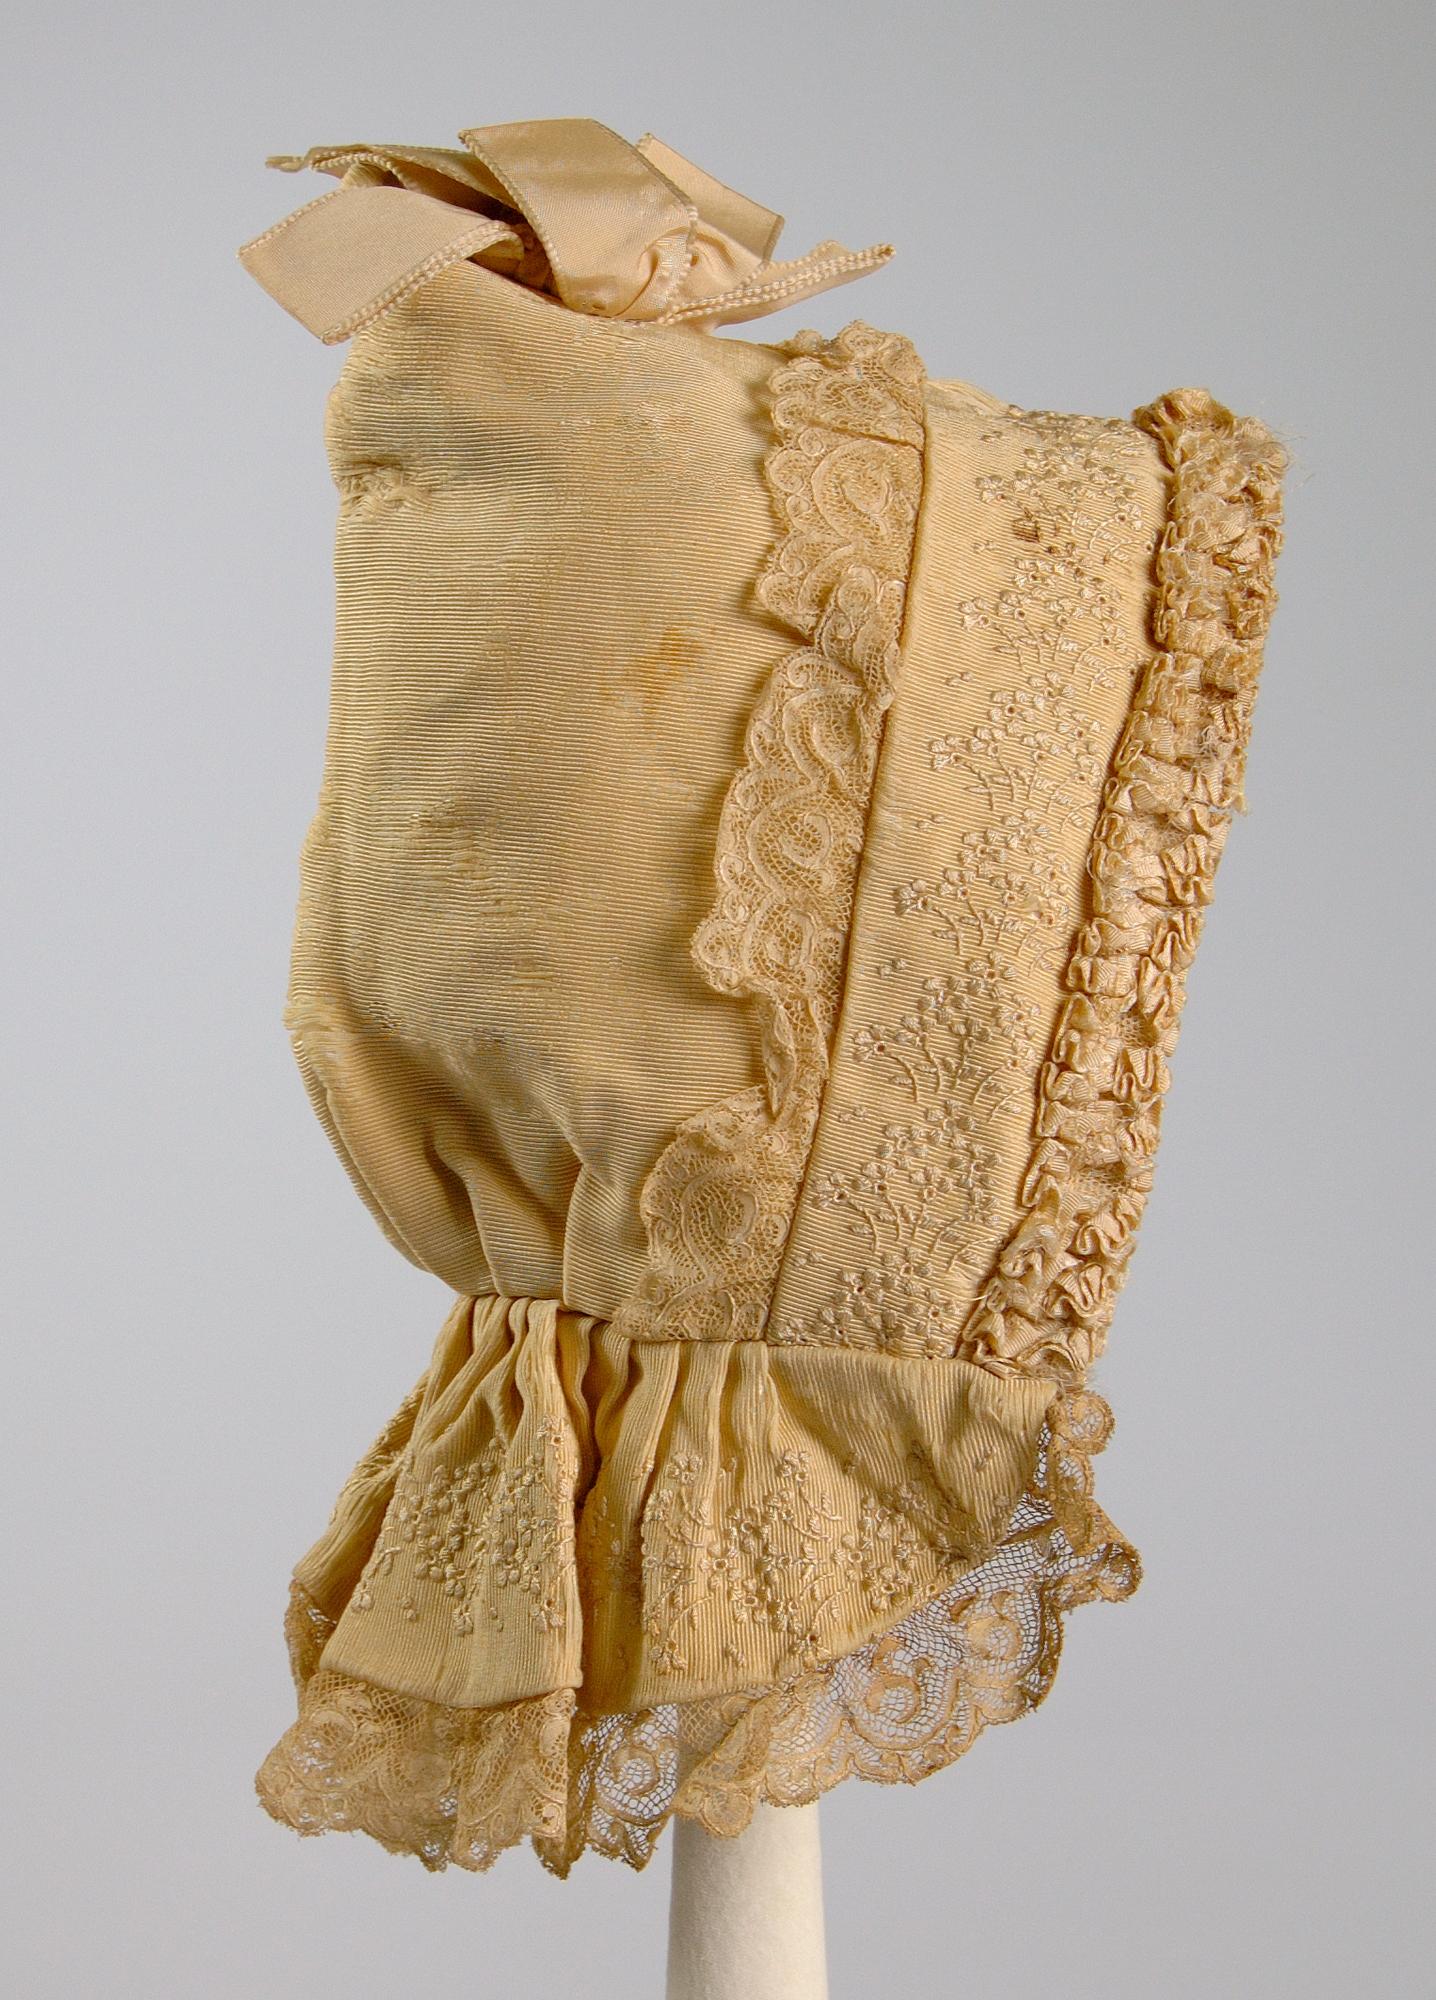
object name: bonnet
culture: american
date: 1890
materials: linen, silk